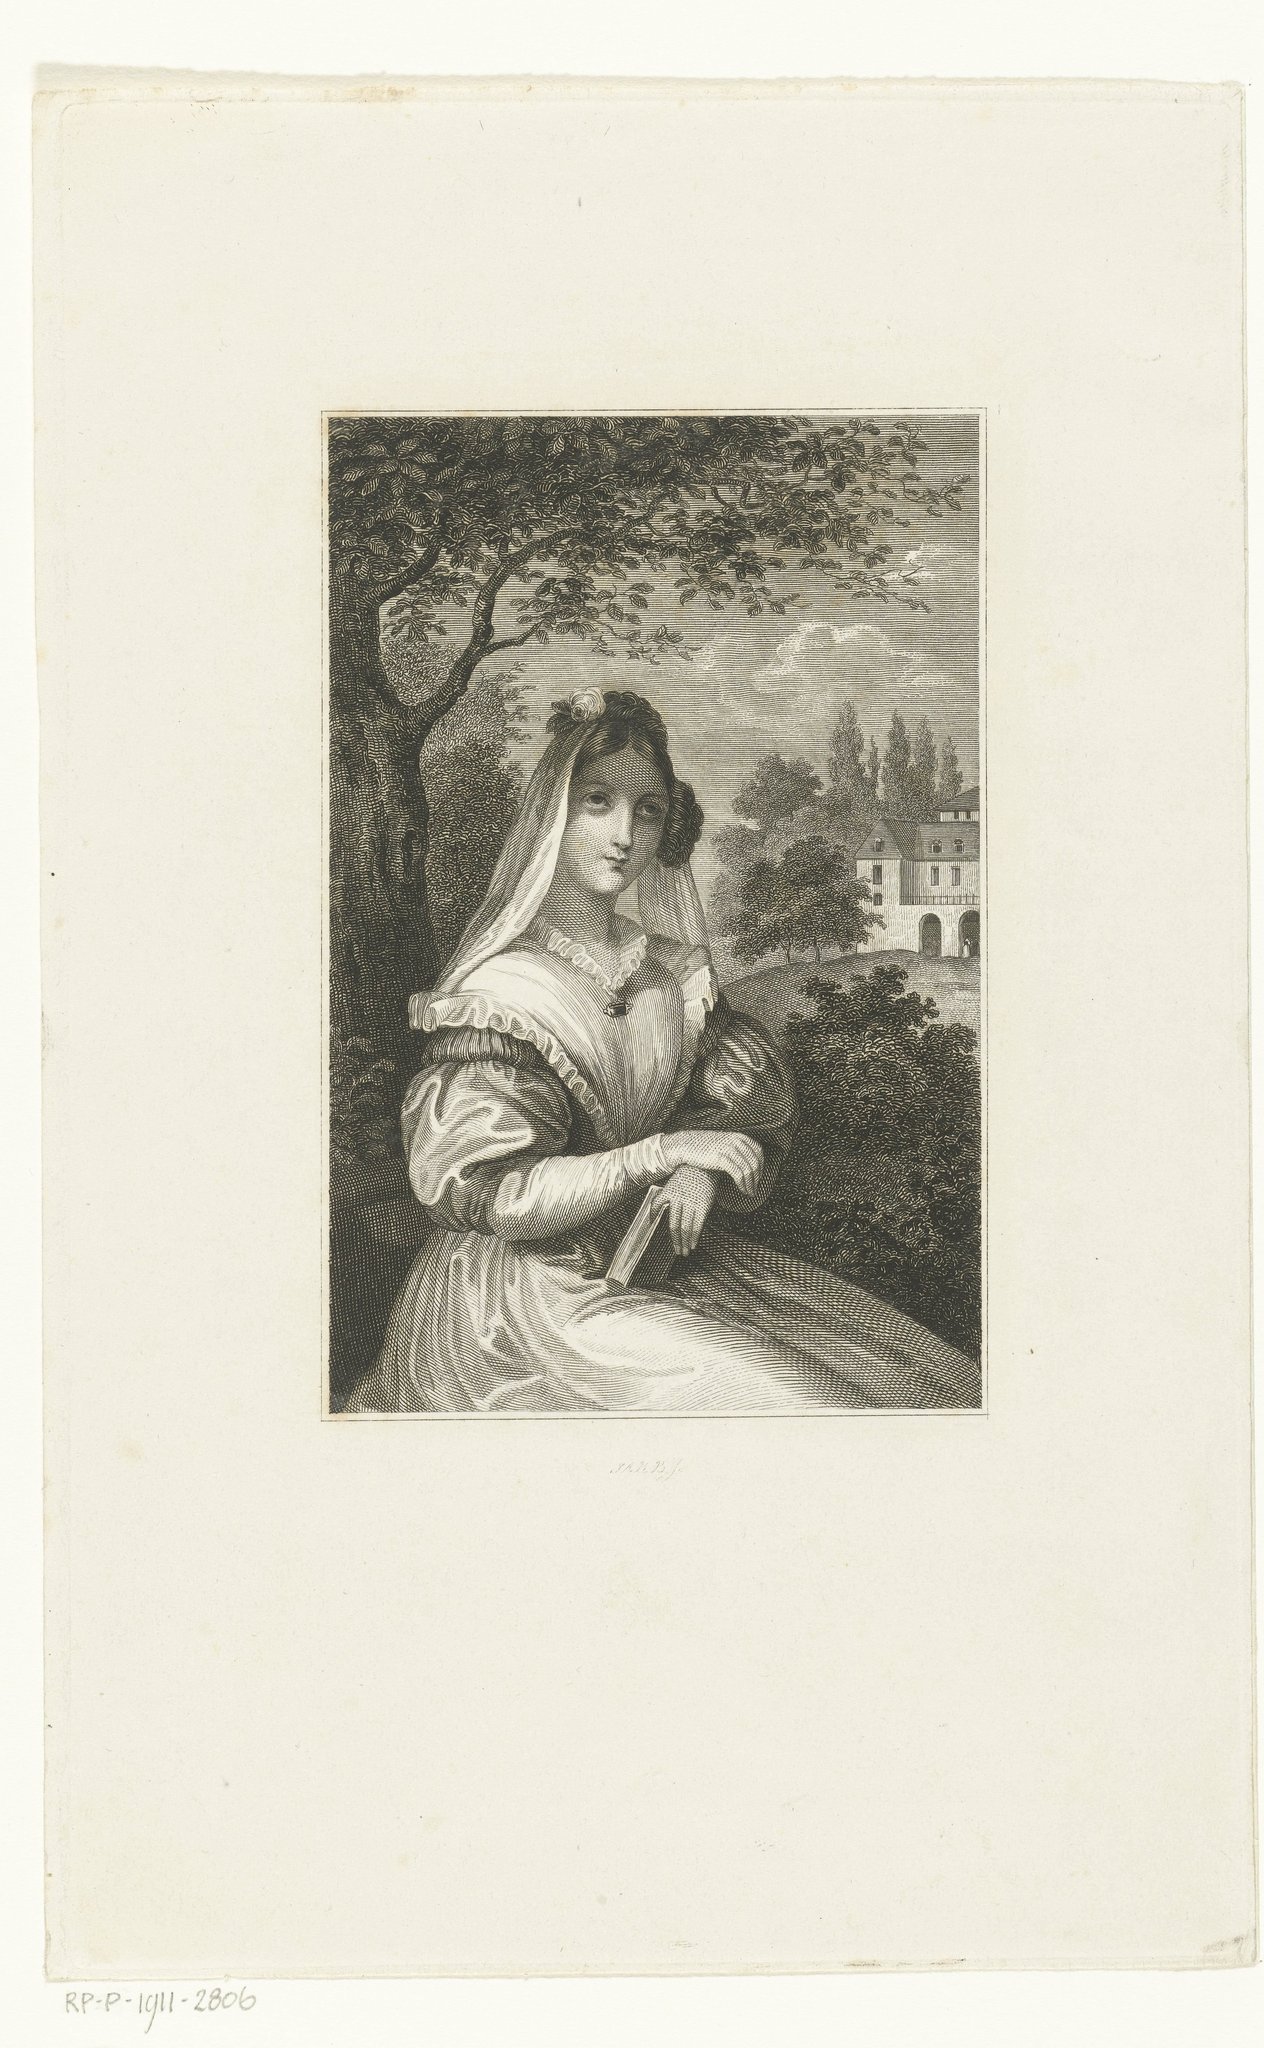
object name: print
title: Dame met sluier en boek zit in tuin bij groot huis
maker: johannes alexander rudolf best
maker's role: print maker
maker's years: 1797-1855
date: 1807-1855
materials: paper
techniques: engraving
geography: amsterdam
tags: reading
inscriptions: collector's mark: Lugt 2228